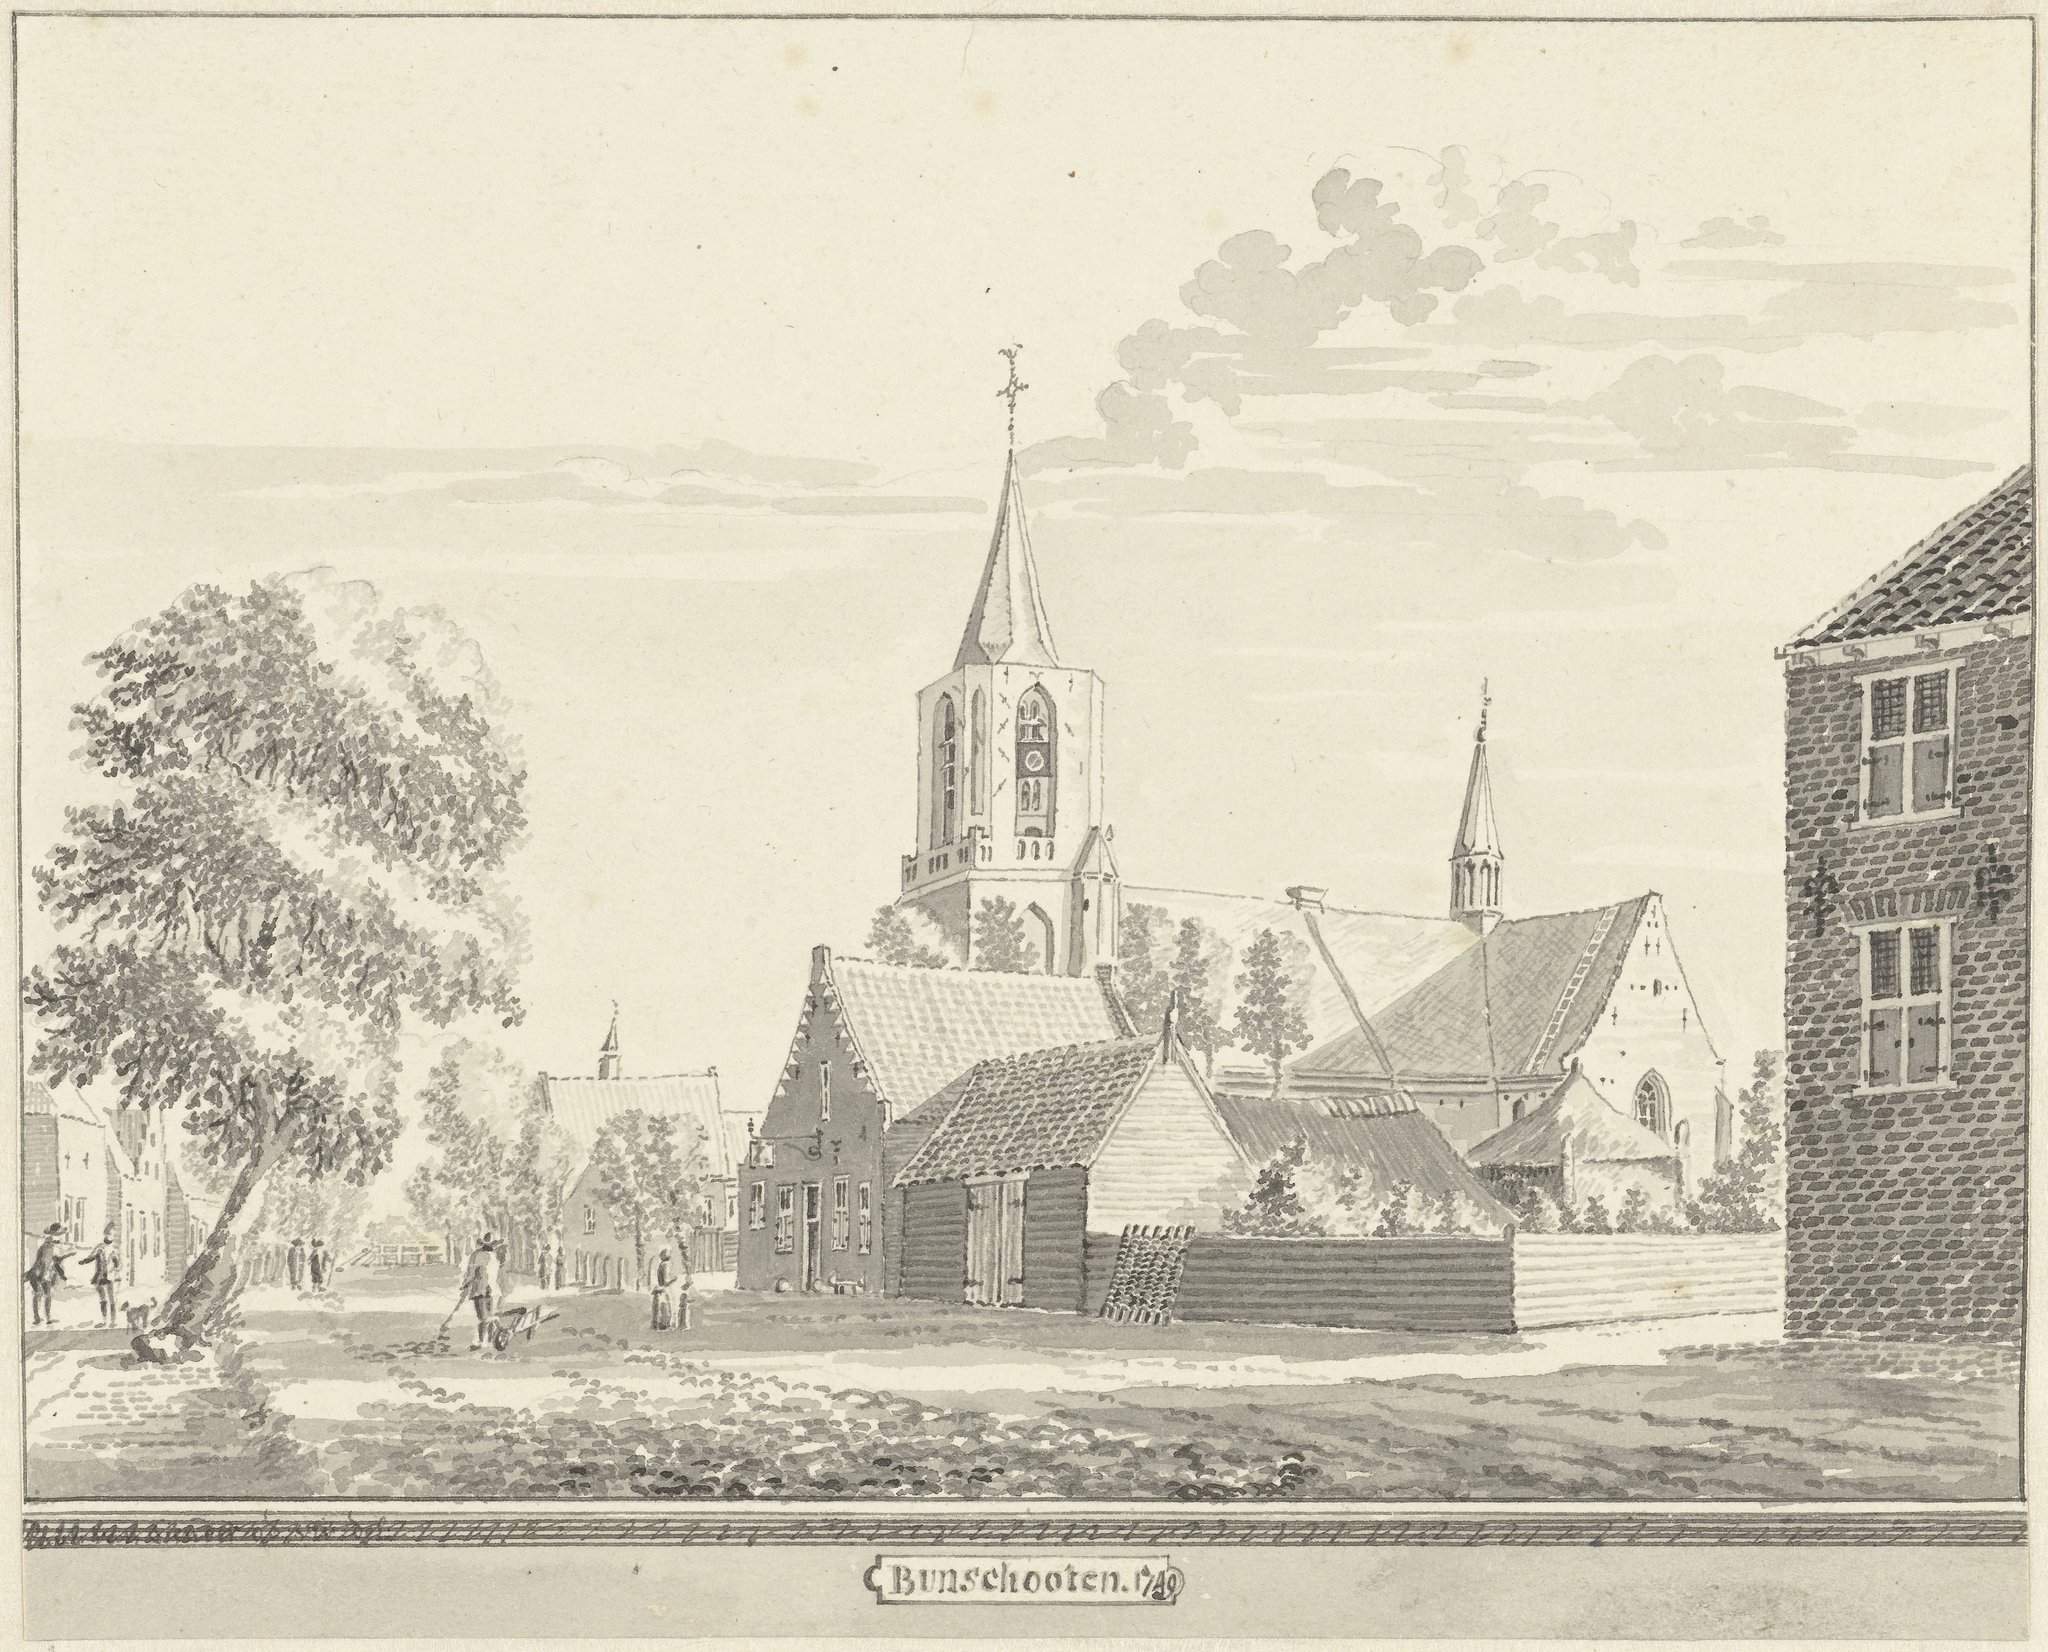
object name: drawing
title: Gezicht te Bunschoten, met de kerk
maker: abraham de haen (ii)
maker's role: draughtsman, print maker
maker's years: 1707-1748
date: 1717-1748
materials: ink, paper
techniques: brush, pen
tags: church (exterior), prospect of city, town panorama, silhouette of city